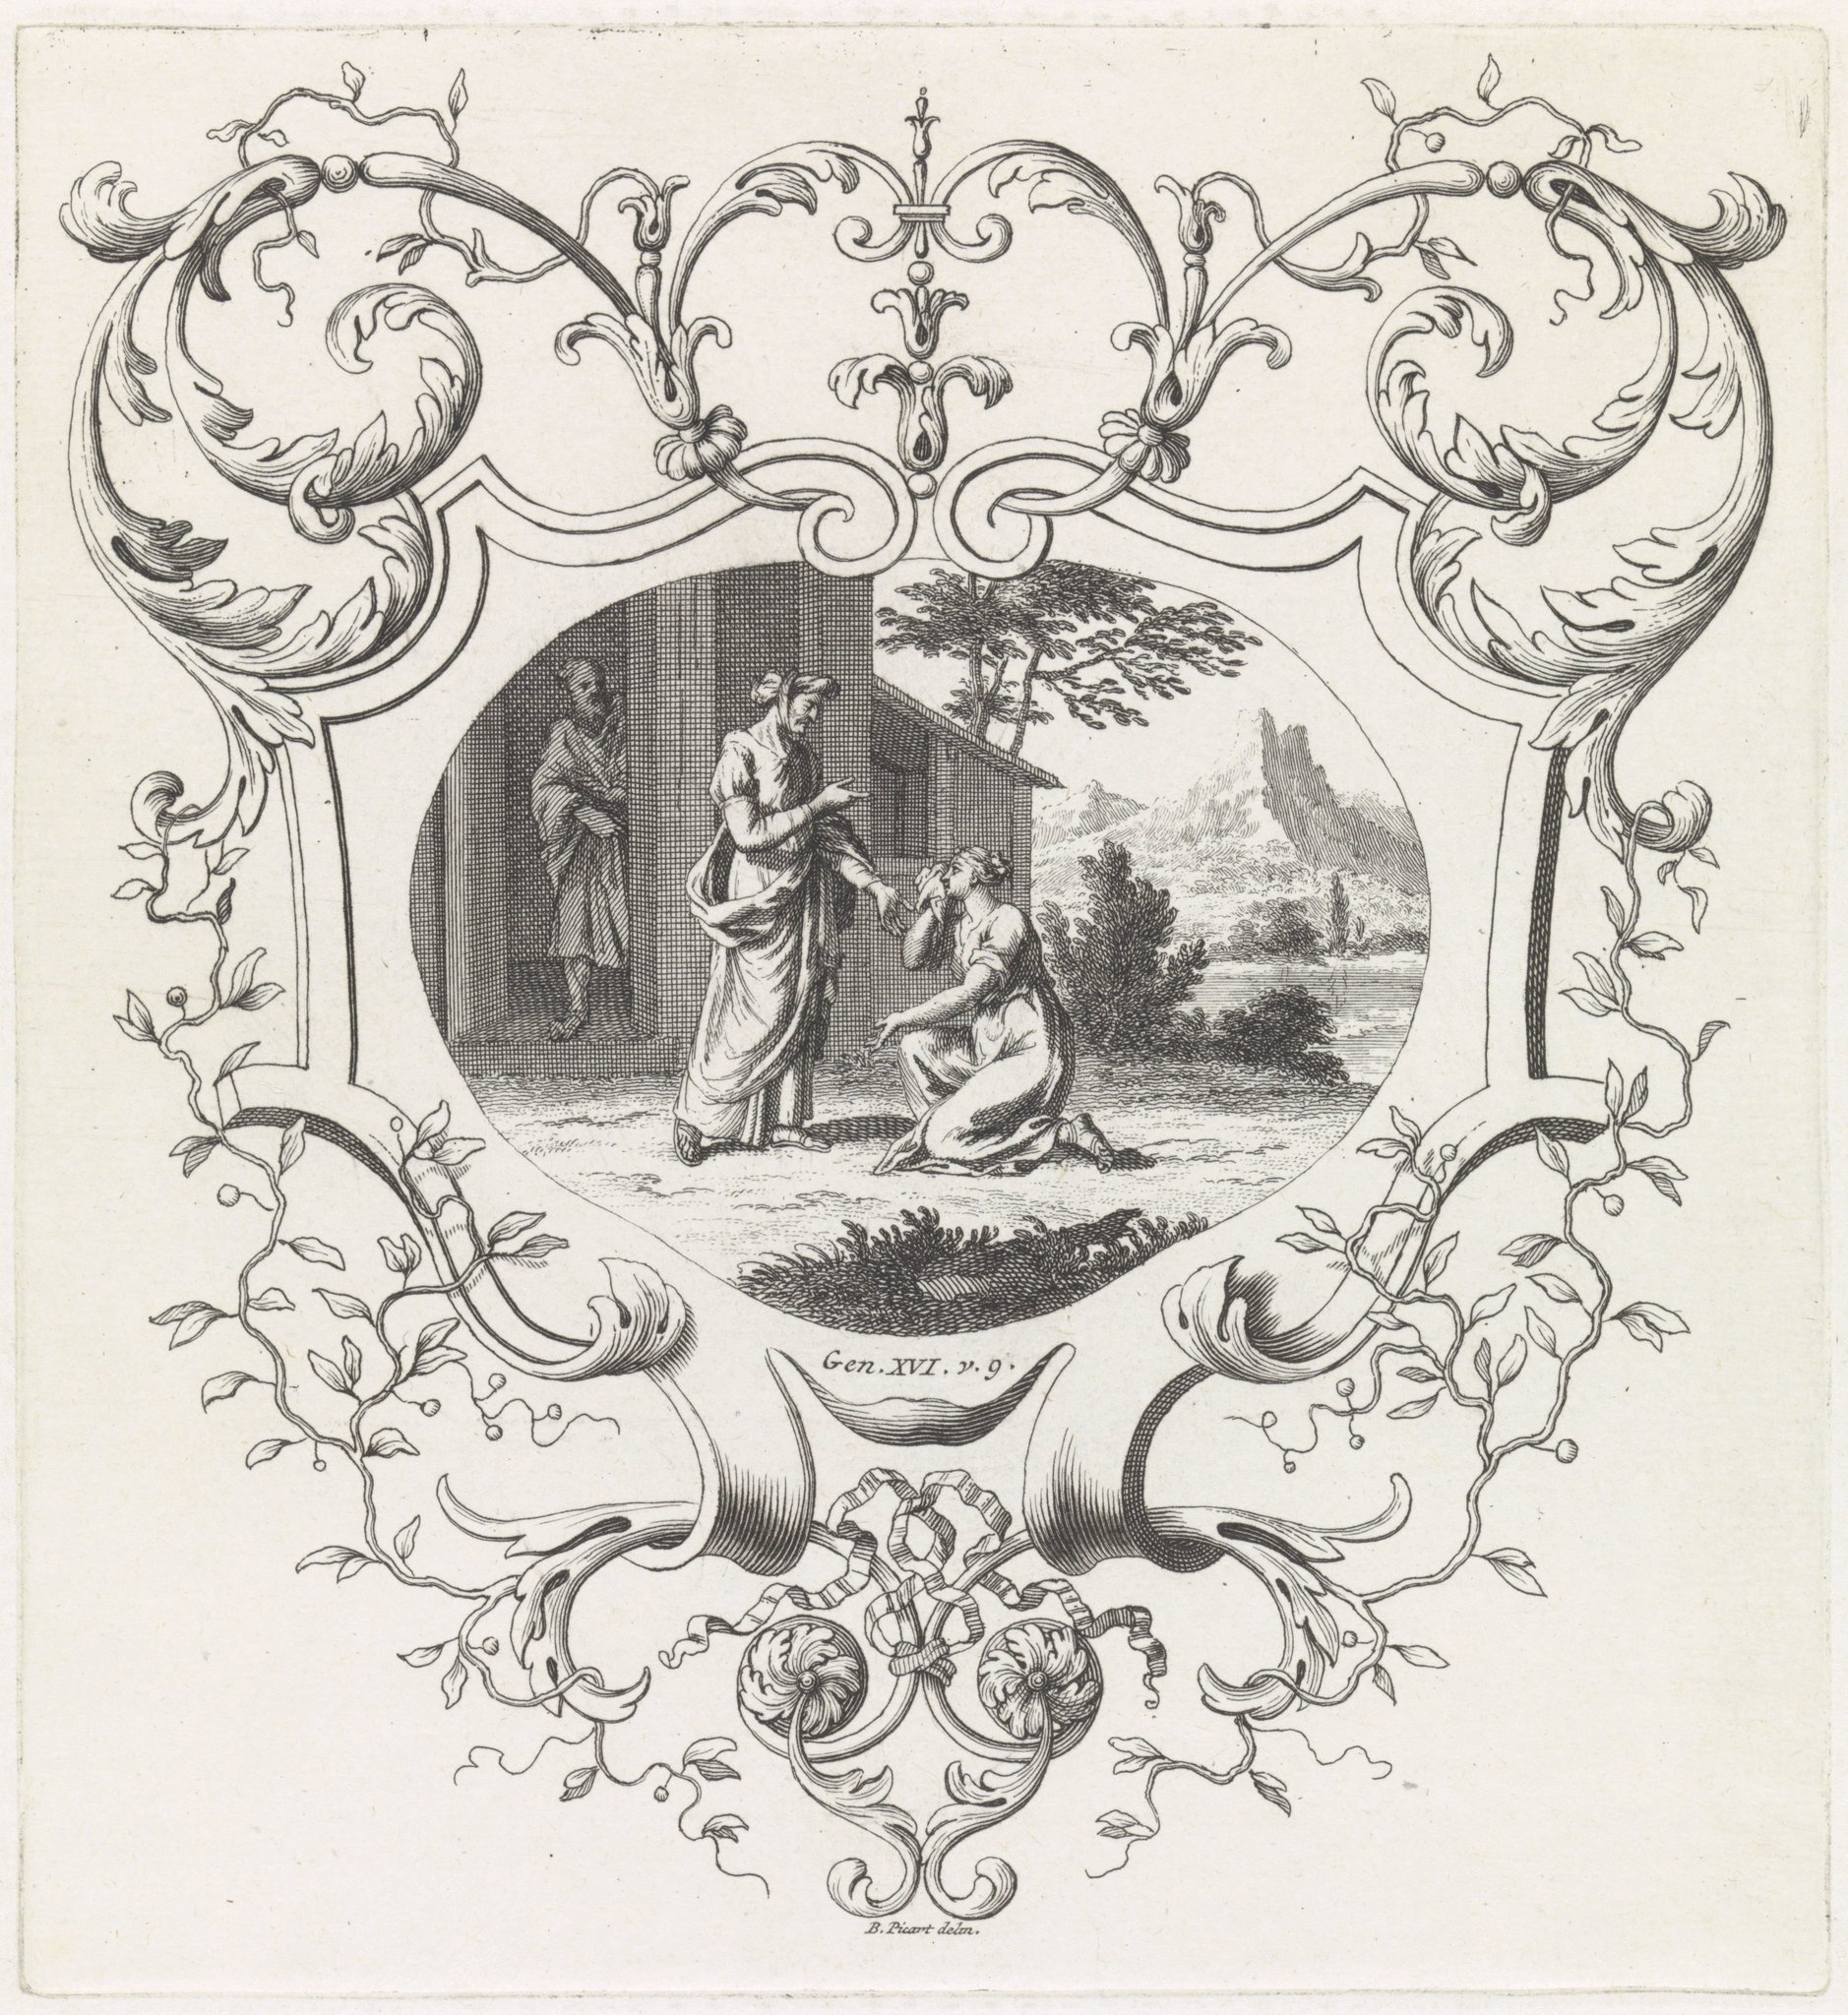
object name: print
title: Hagar keert terug naar Sara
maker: bernard picart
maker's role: draughtsman, print maker, publisher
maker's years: 1673-1733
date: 1683-1733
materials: paper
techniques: engraving, etching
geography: amsterdam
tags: scrollwork, strapwork ~ ornament, foliage, tendrils, branches ~ ornament, hagar returns to abraham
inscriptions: collector's mark: Lugt 2233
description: Prent oorspronkelijk bedoeld voor: Figures de la Bible. Amsterdam, Bernard Picart, 1720. Prent ook gebruikt in: Taferelen der voornaamste geschiedenissen van het Oude en Nieuwe Testament (...) door de vermaarde kunstenaars Hoet, Houbraken, en Picart getekent (...) en met beschrijvingen uitgebreid. Den Haag: Pieter de Hondt, 1728. Prent kan mogelijk ook zijn gebruikt in andere bijbels.